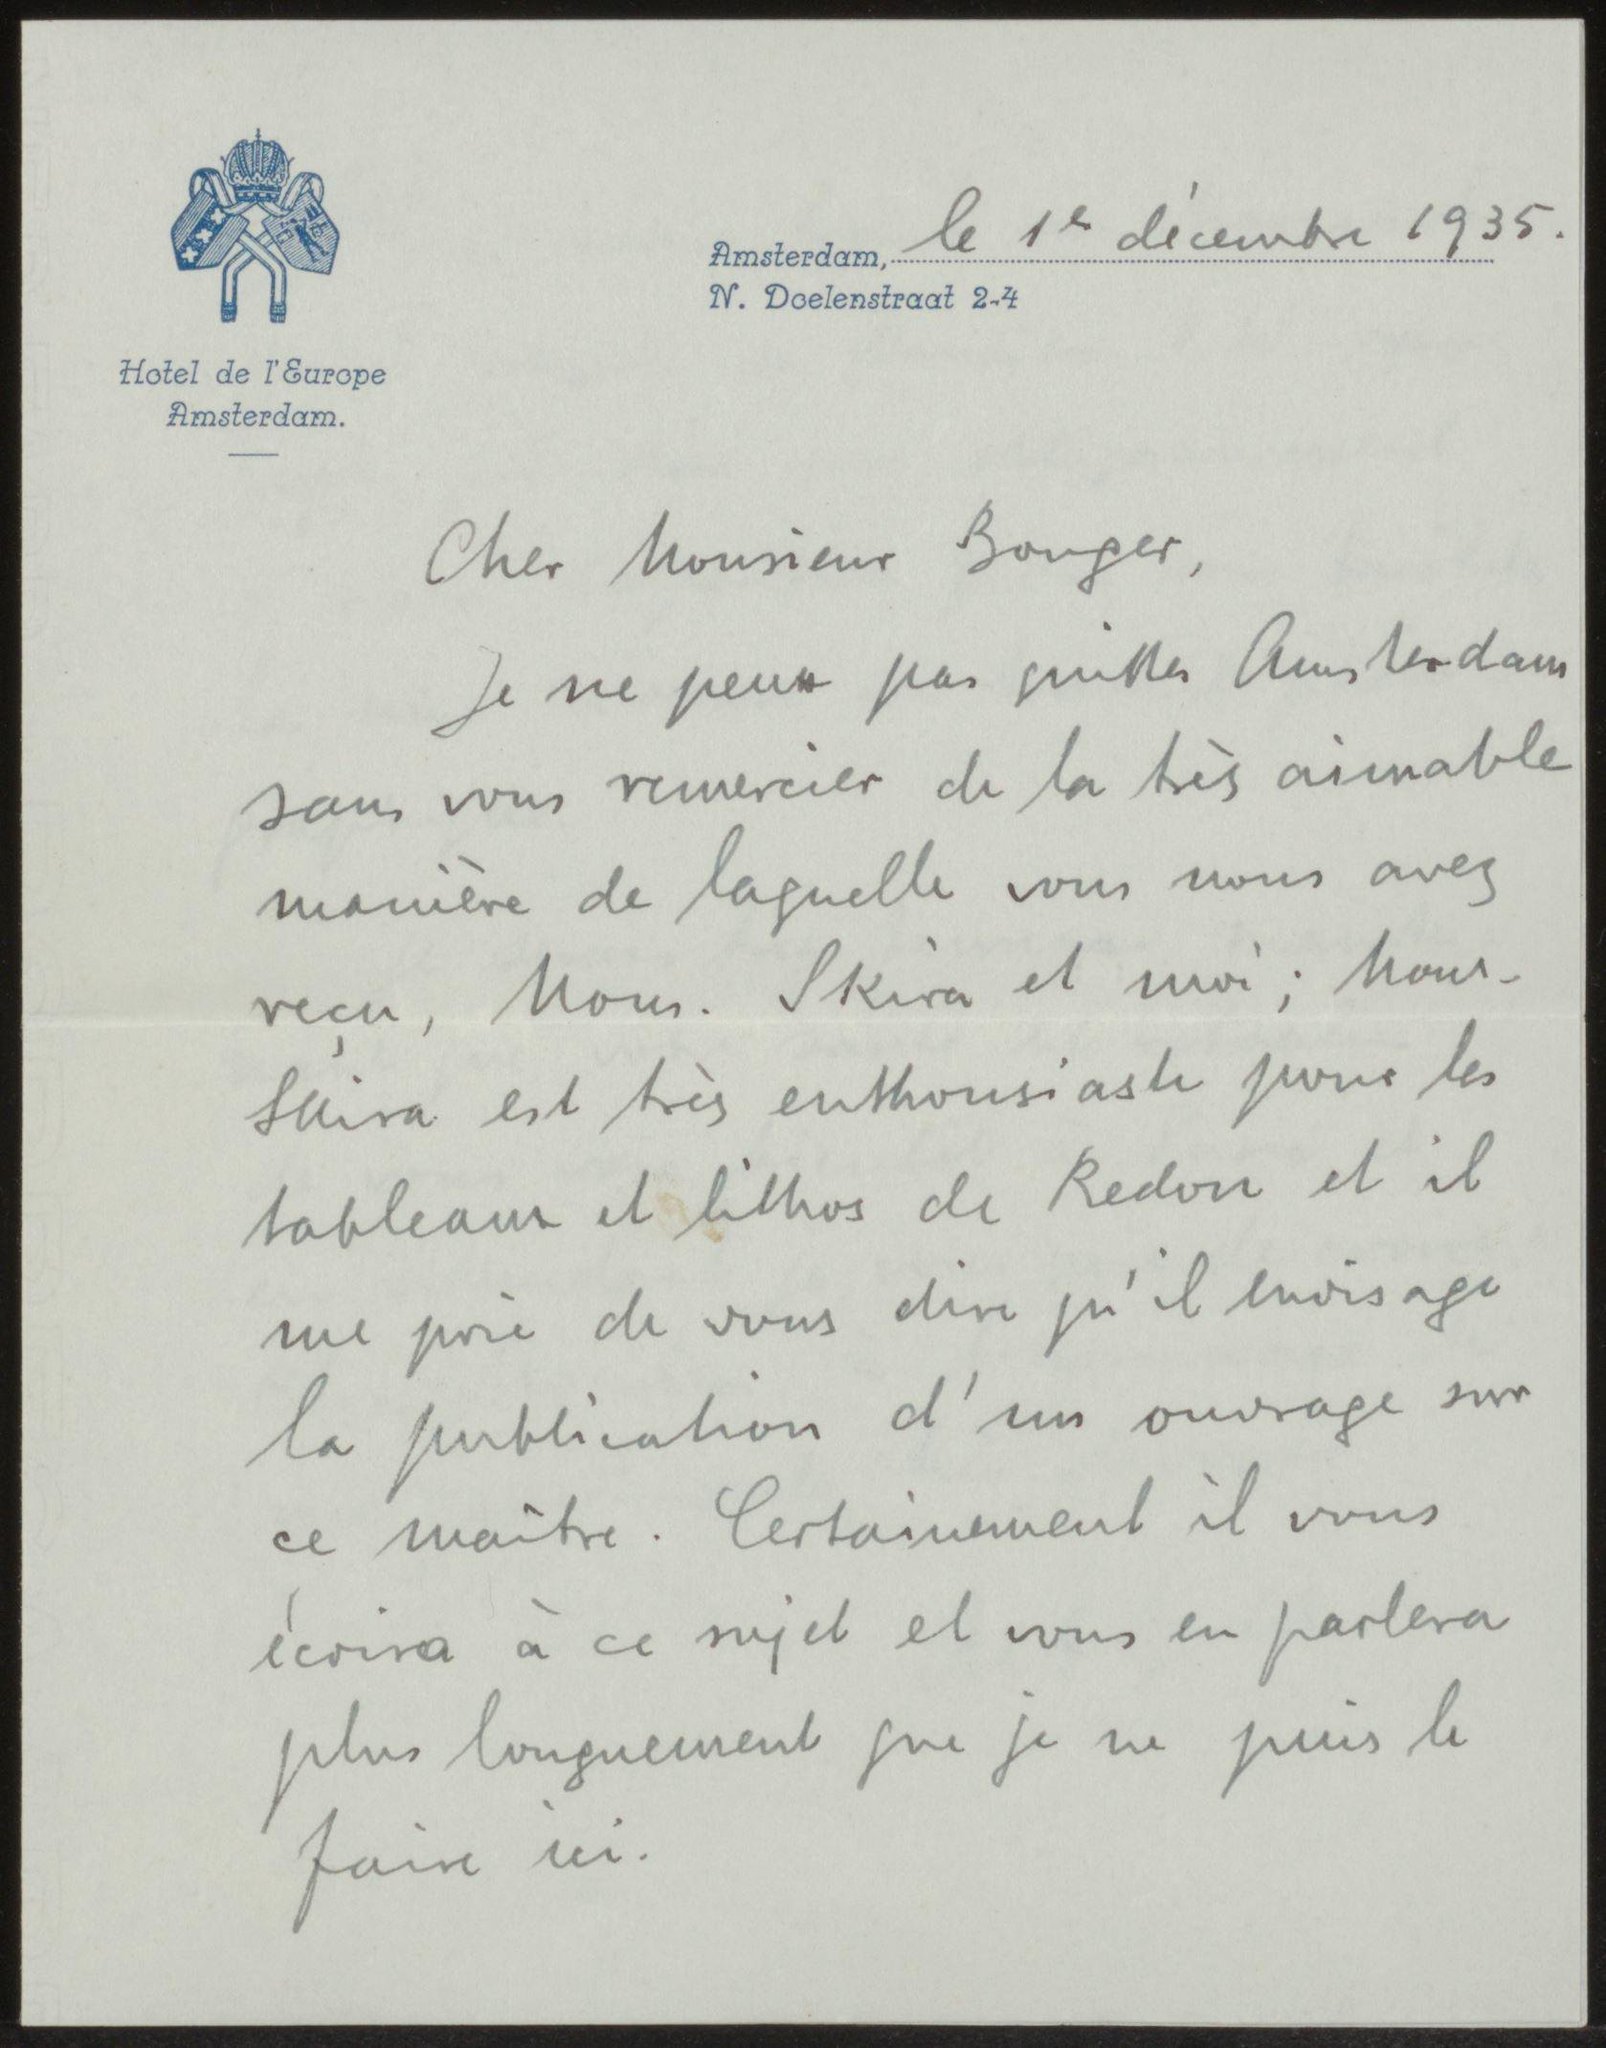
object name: letter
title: Brief aan Andries Bonger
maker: art gold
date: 1935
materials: ink, paper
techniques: pen, printing, writing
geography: amsterdam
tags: paris, painter, print maker, odilon redon, amsterdam, andries bonger, vincent willem van gogh, photography, cinematography, the graphic arts, painting (including book-illumination, miniature-painting), printed matter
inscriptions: watermark